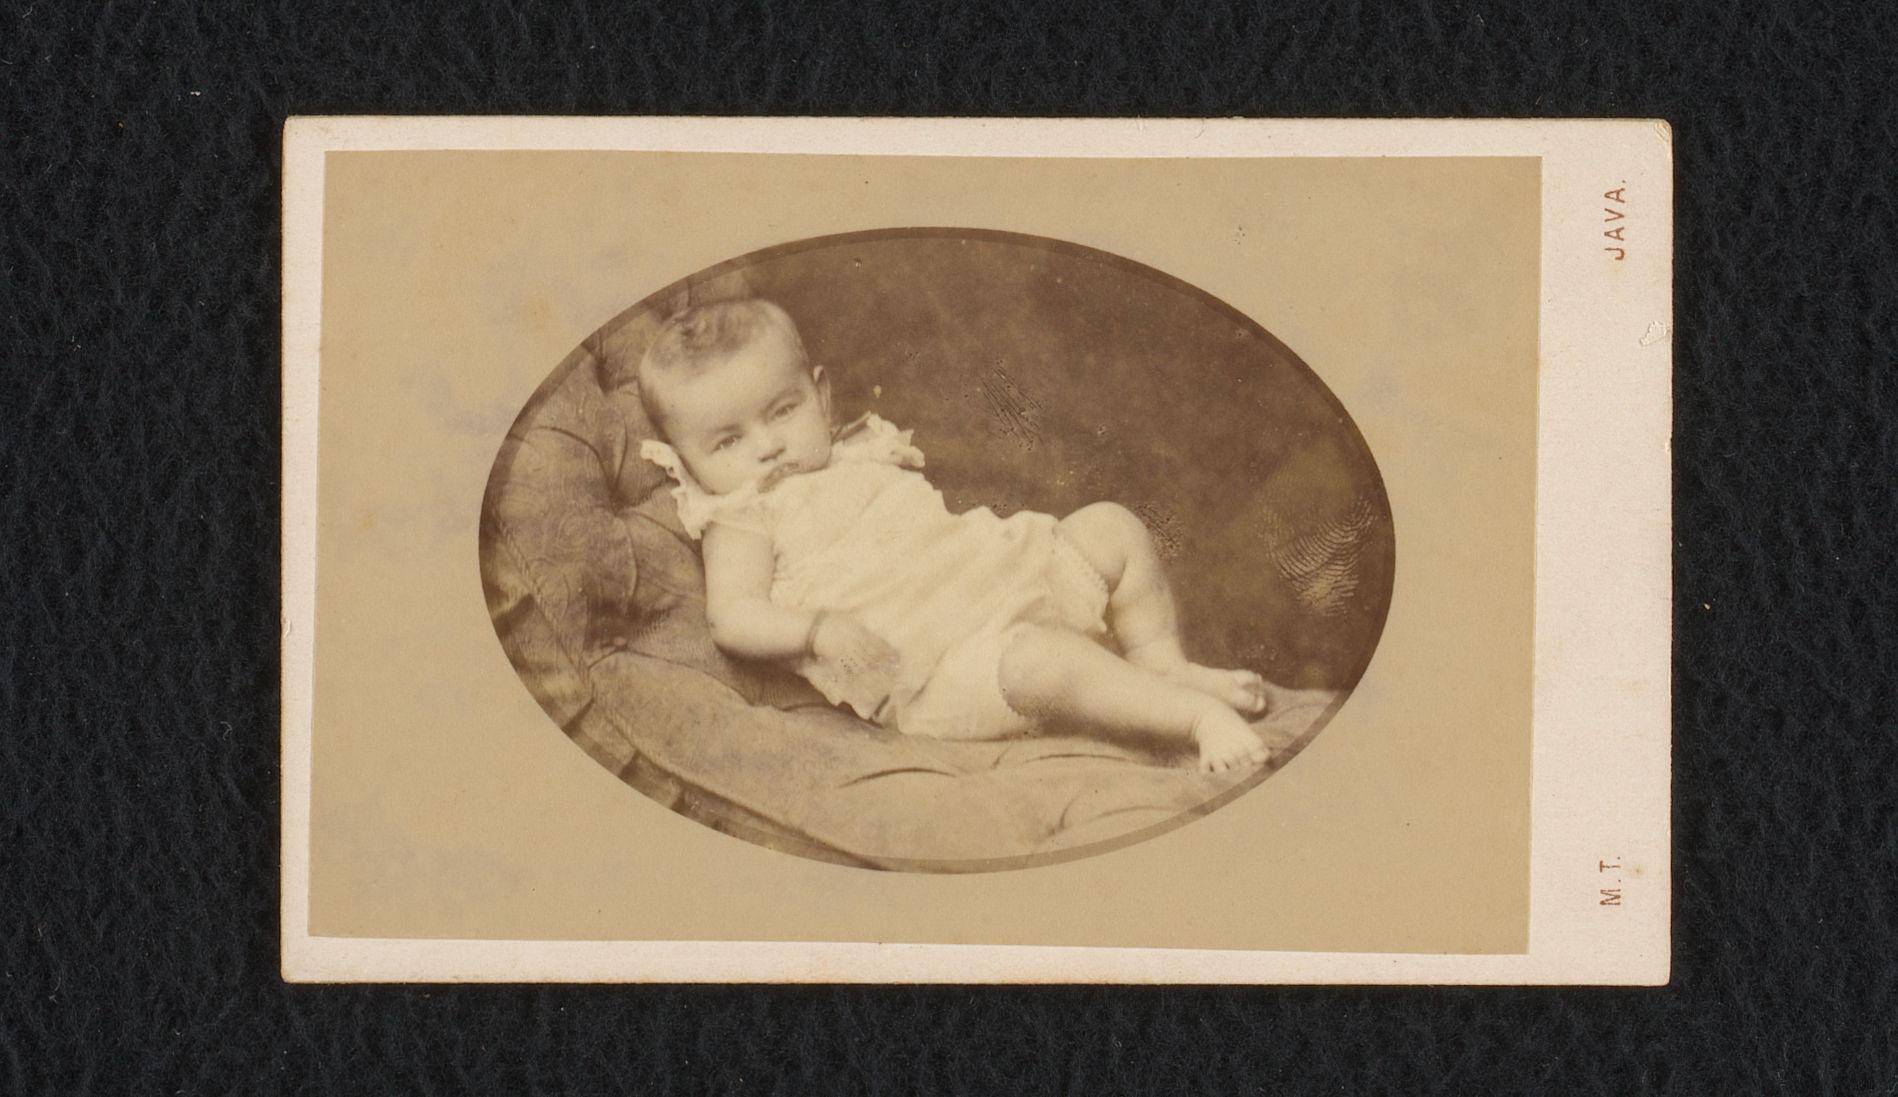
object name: carte de visite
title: Portret van Wilhelmina Spruijt Landskroon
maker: m. taggeselle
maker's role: fotograaf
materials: cardboard, paper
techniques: albumen print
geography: java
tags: historical persons - bb - woman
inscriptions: inscription: ‘Wilhelmina/ Johanna Spruyt/ Landskroon/ 5 maanden oud.’